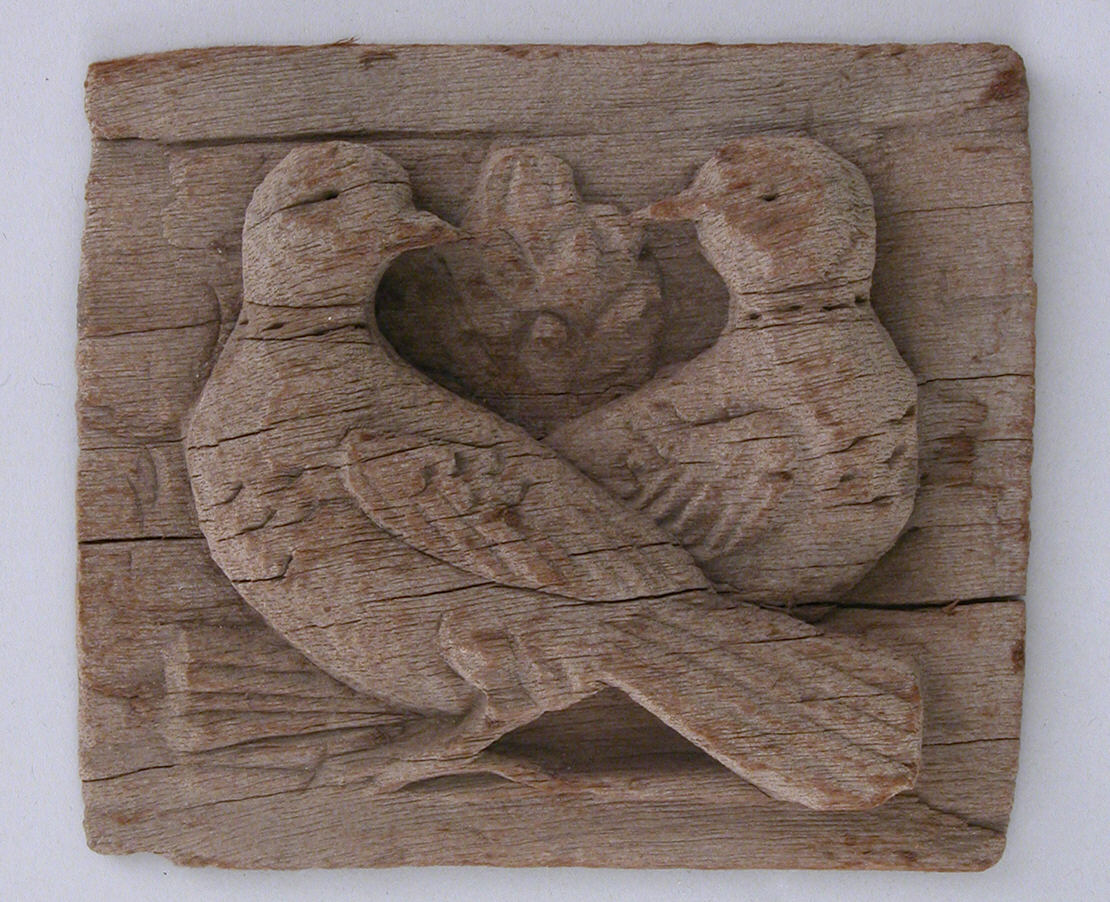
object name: panel with bird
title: Panel with Birds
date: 301-500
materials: wood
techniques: carving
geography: egypt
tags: birds